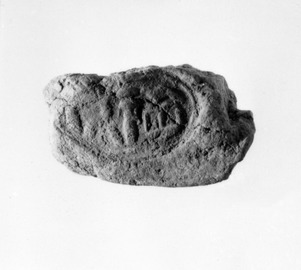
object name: sealing, nebmaatre, amenhotep iii, heb sed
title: Document Sealing With the Throne Name of Amenhotep III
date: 1390-1352 BCE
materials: mud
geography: egypt